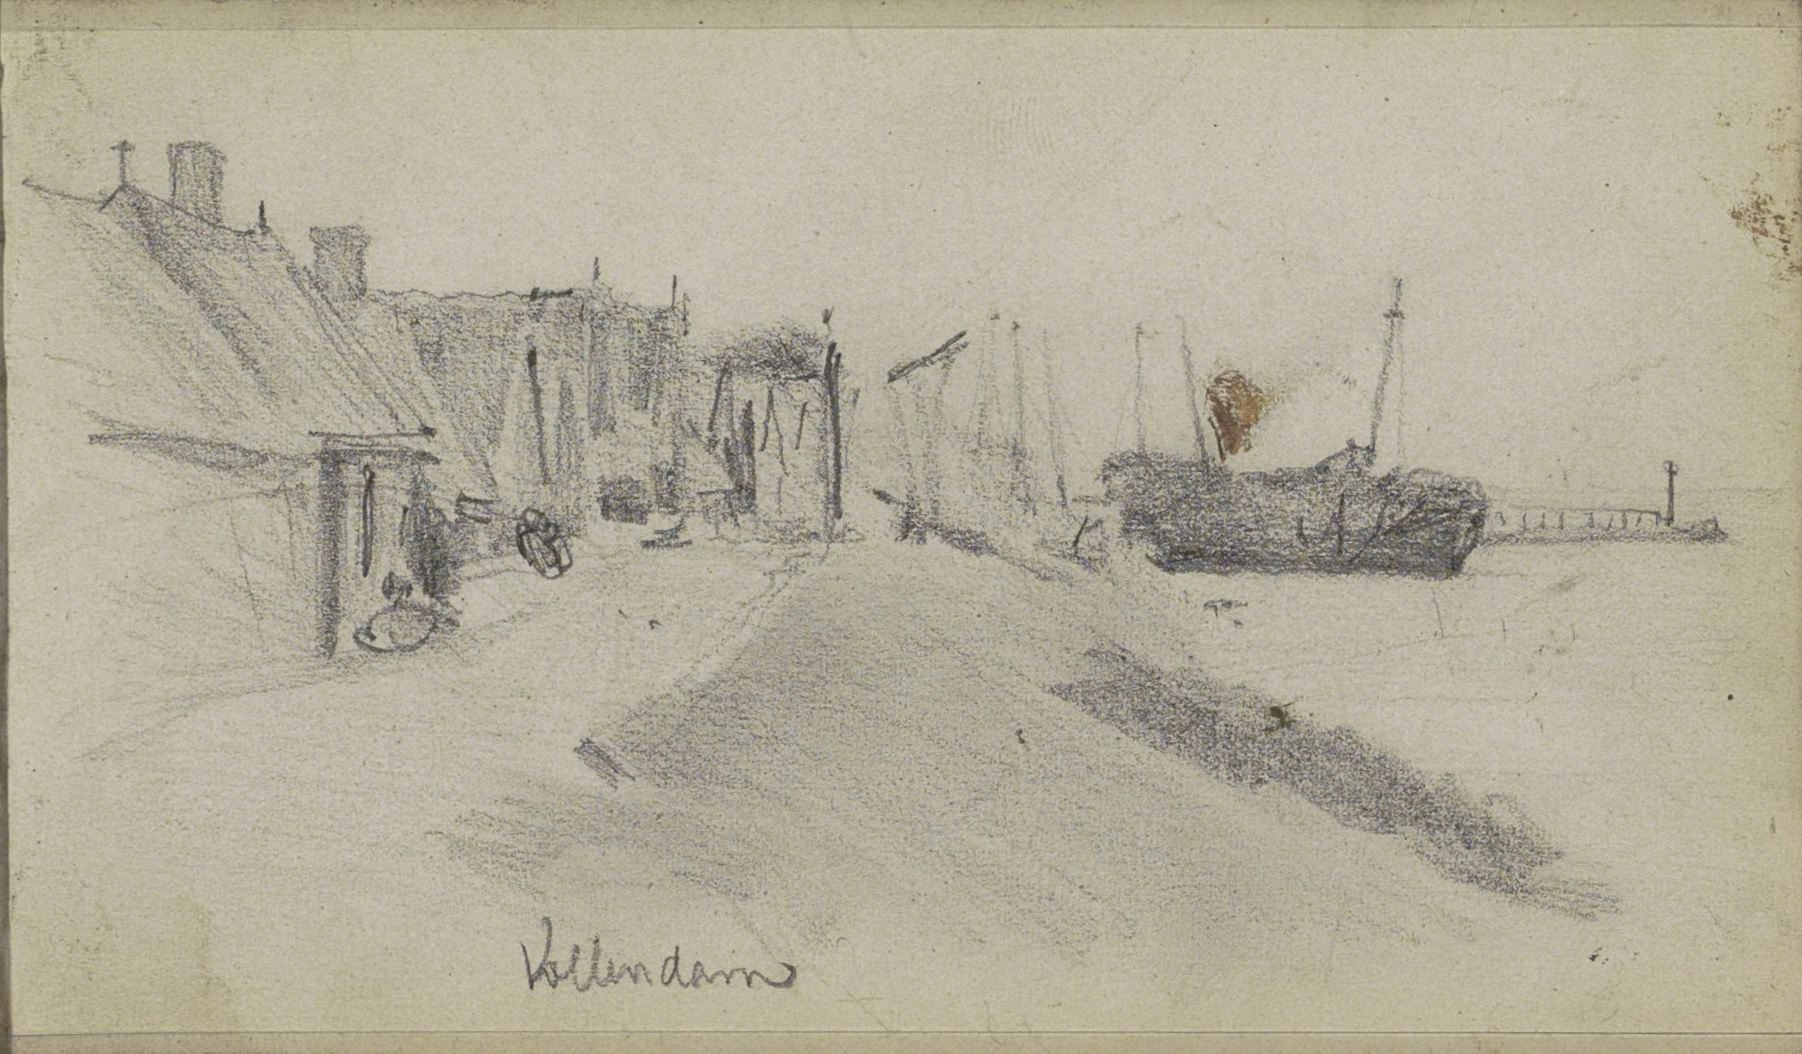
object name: sketchbook leaf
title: Huizen aan de kade van Volendam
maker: george clausen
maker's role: draughtsman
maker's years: 1852-1912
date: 1875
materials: paper, pencil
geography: volendam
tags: sailing-ship, sailing-boat, village street, housing, pier, quay, wharf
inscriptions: annotation: ‘Volendam’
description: Op de achtergrond enkele aangemeerde vissersboten. Blad 33 recto uit een schetsboek met 46 bladen.